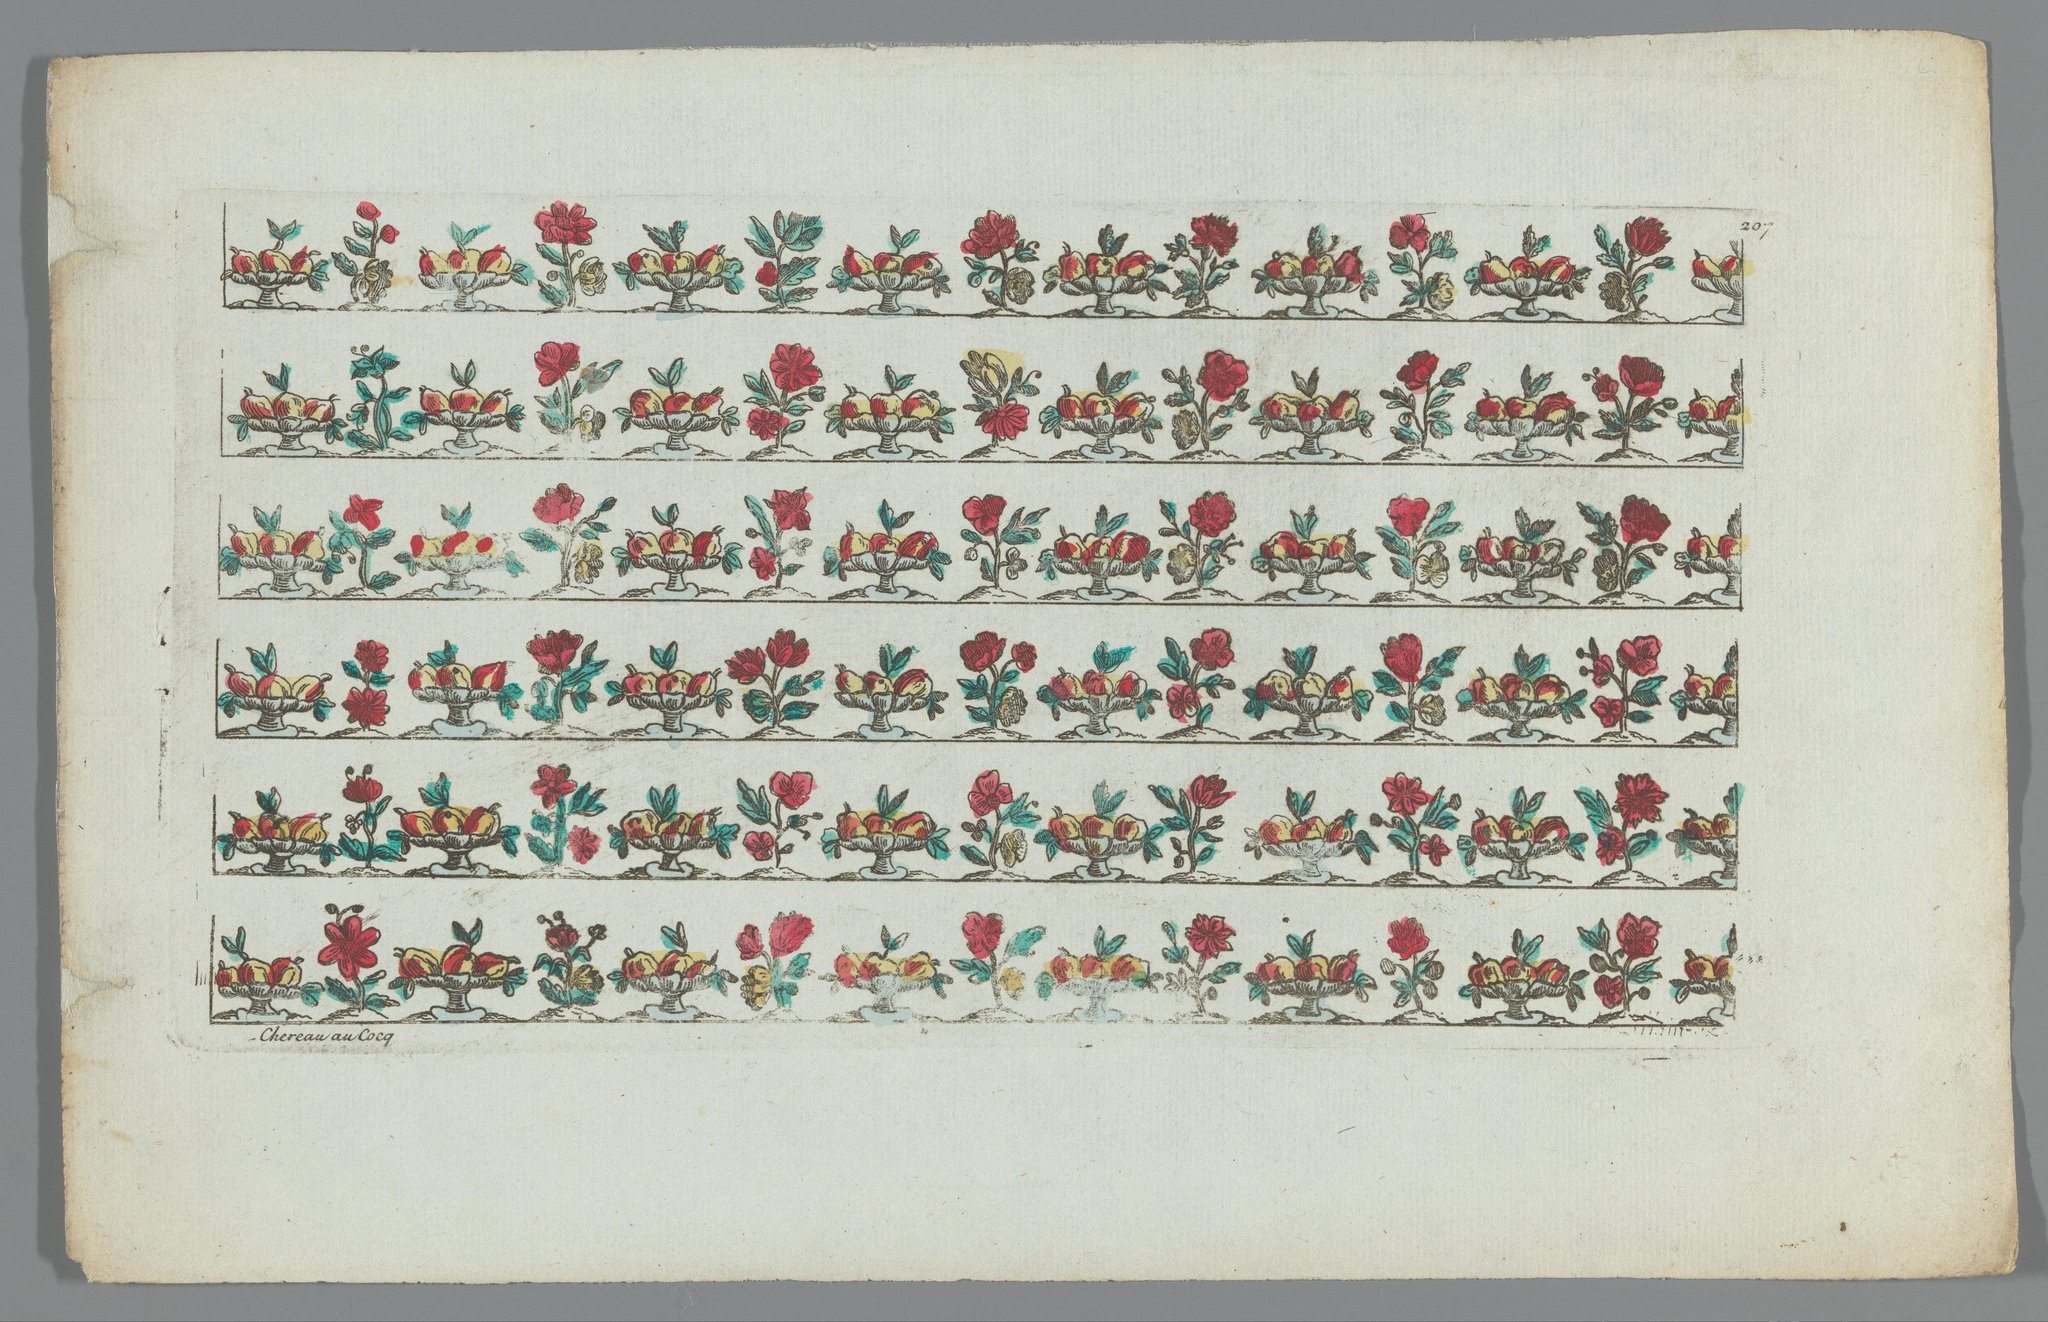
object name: print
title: Decoratieve randen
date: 1750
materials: paper, watercolor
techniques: etching, hand coloring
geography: paris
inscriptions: collector's mark: Lugt 2228, collector's mark: Lugt 2760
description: Blad met zeven identieke decoratieve randen opgebouwd uit bloemen en fruitschalen. Rechtsboven genummerd: 207. Een van 39 bladen met knipplaatjes en decoratieve randen.